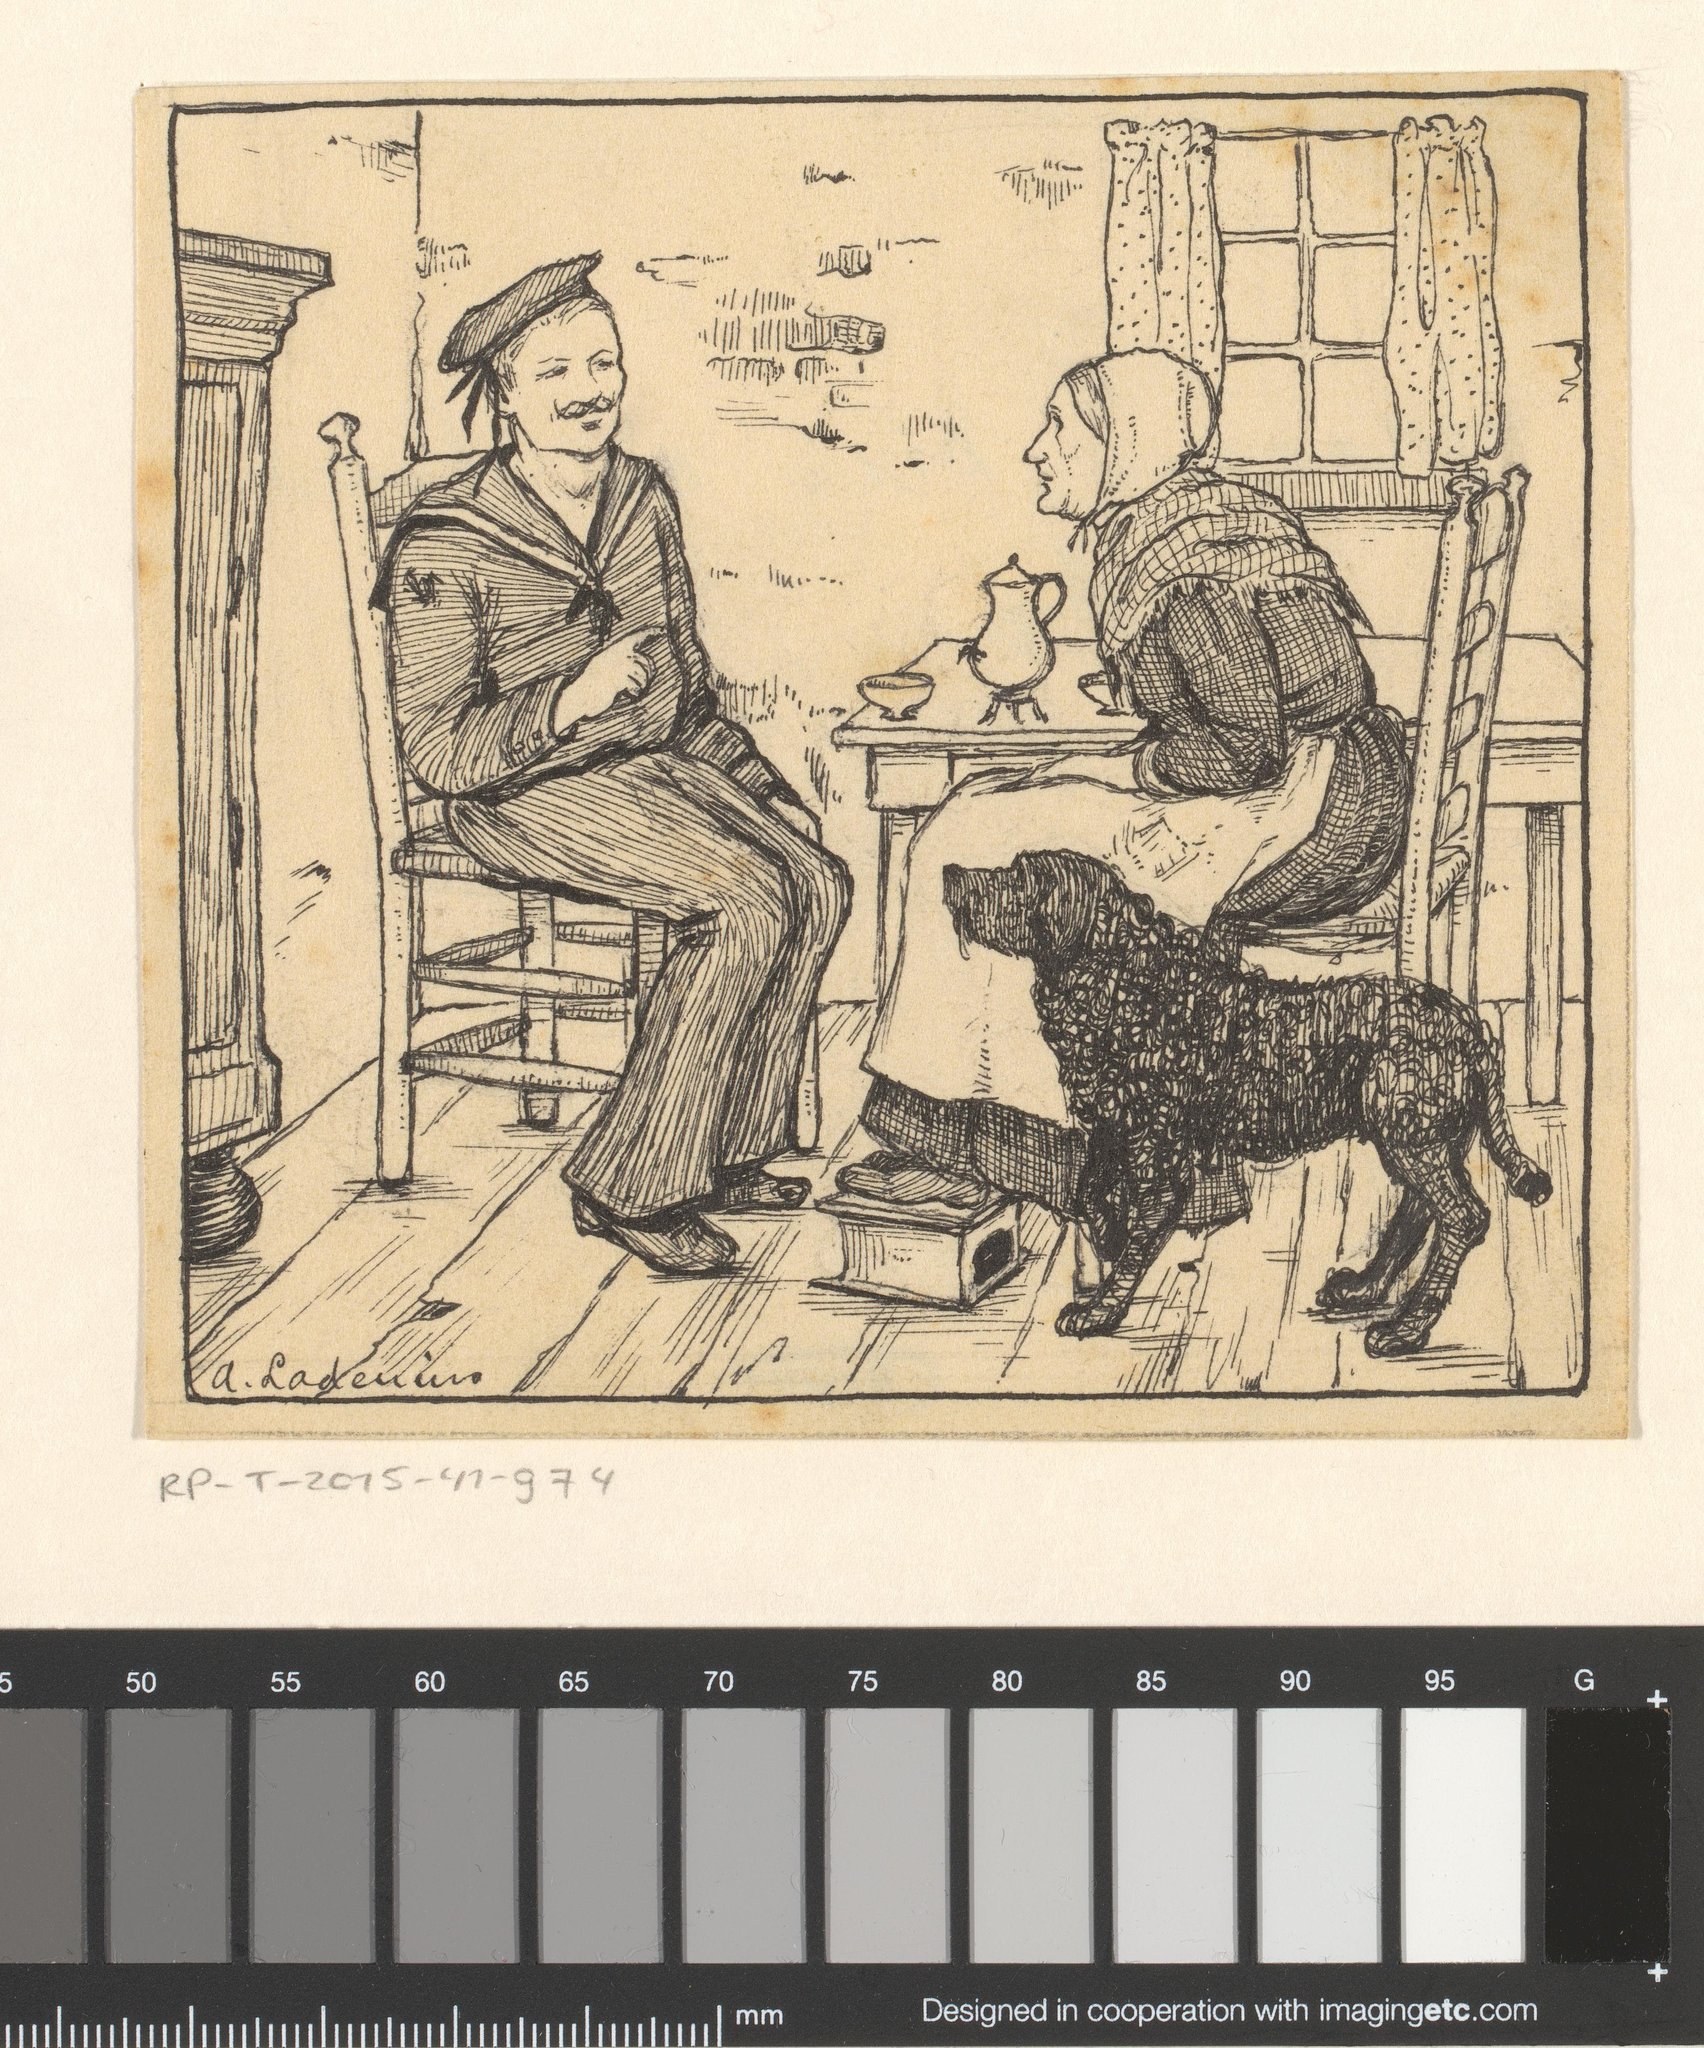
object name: drawing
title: Matroos en oude vrouw in een interieur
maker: adri ladenius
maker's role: draughtsman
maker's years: 1883-1953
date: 1893-1953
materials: ink, paper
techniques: pen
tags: sailor, interior of the house, dog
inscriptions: signature: ‘A. Ladenius’, collector's mark: Lugt 2228, annotation: ‘Moeder Dres en haar/ Does.’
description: Een man in een matrozenpak en een oude vrouw zitten in een interieur aan een tafel. De vrouw heeft haar voeten op een stoof en de man gebaart naar een hond.